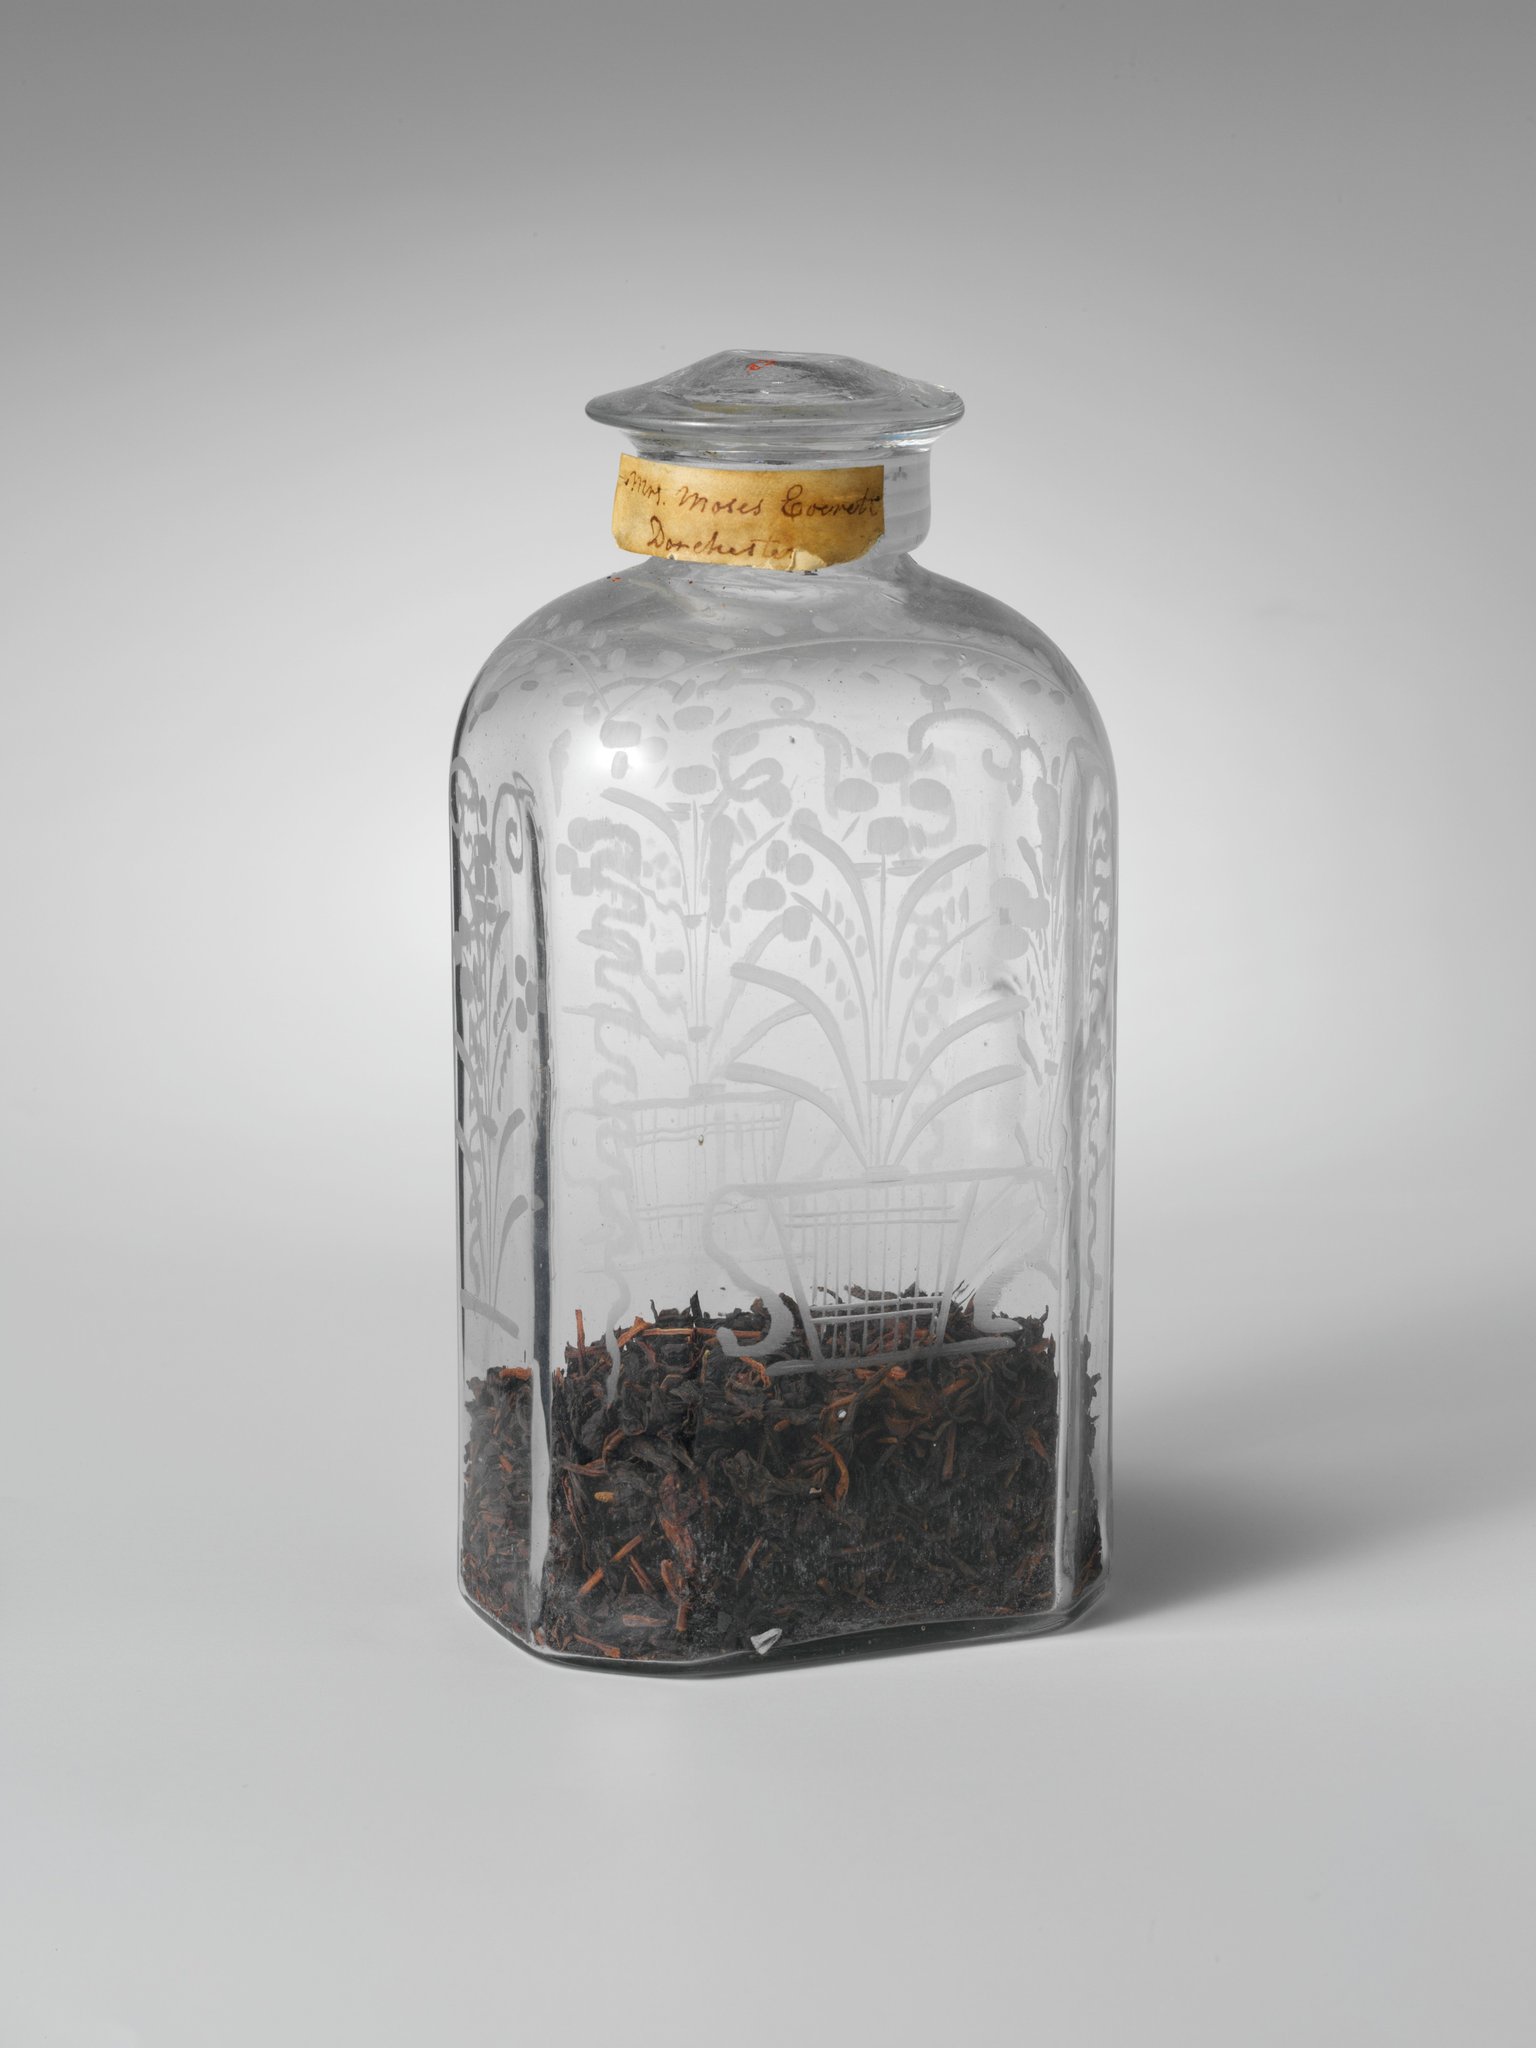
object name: bottle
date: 1770-1820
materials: glass, lead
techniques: engraving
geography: czech republic